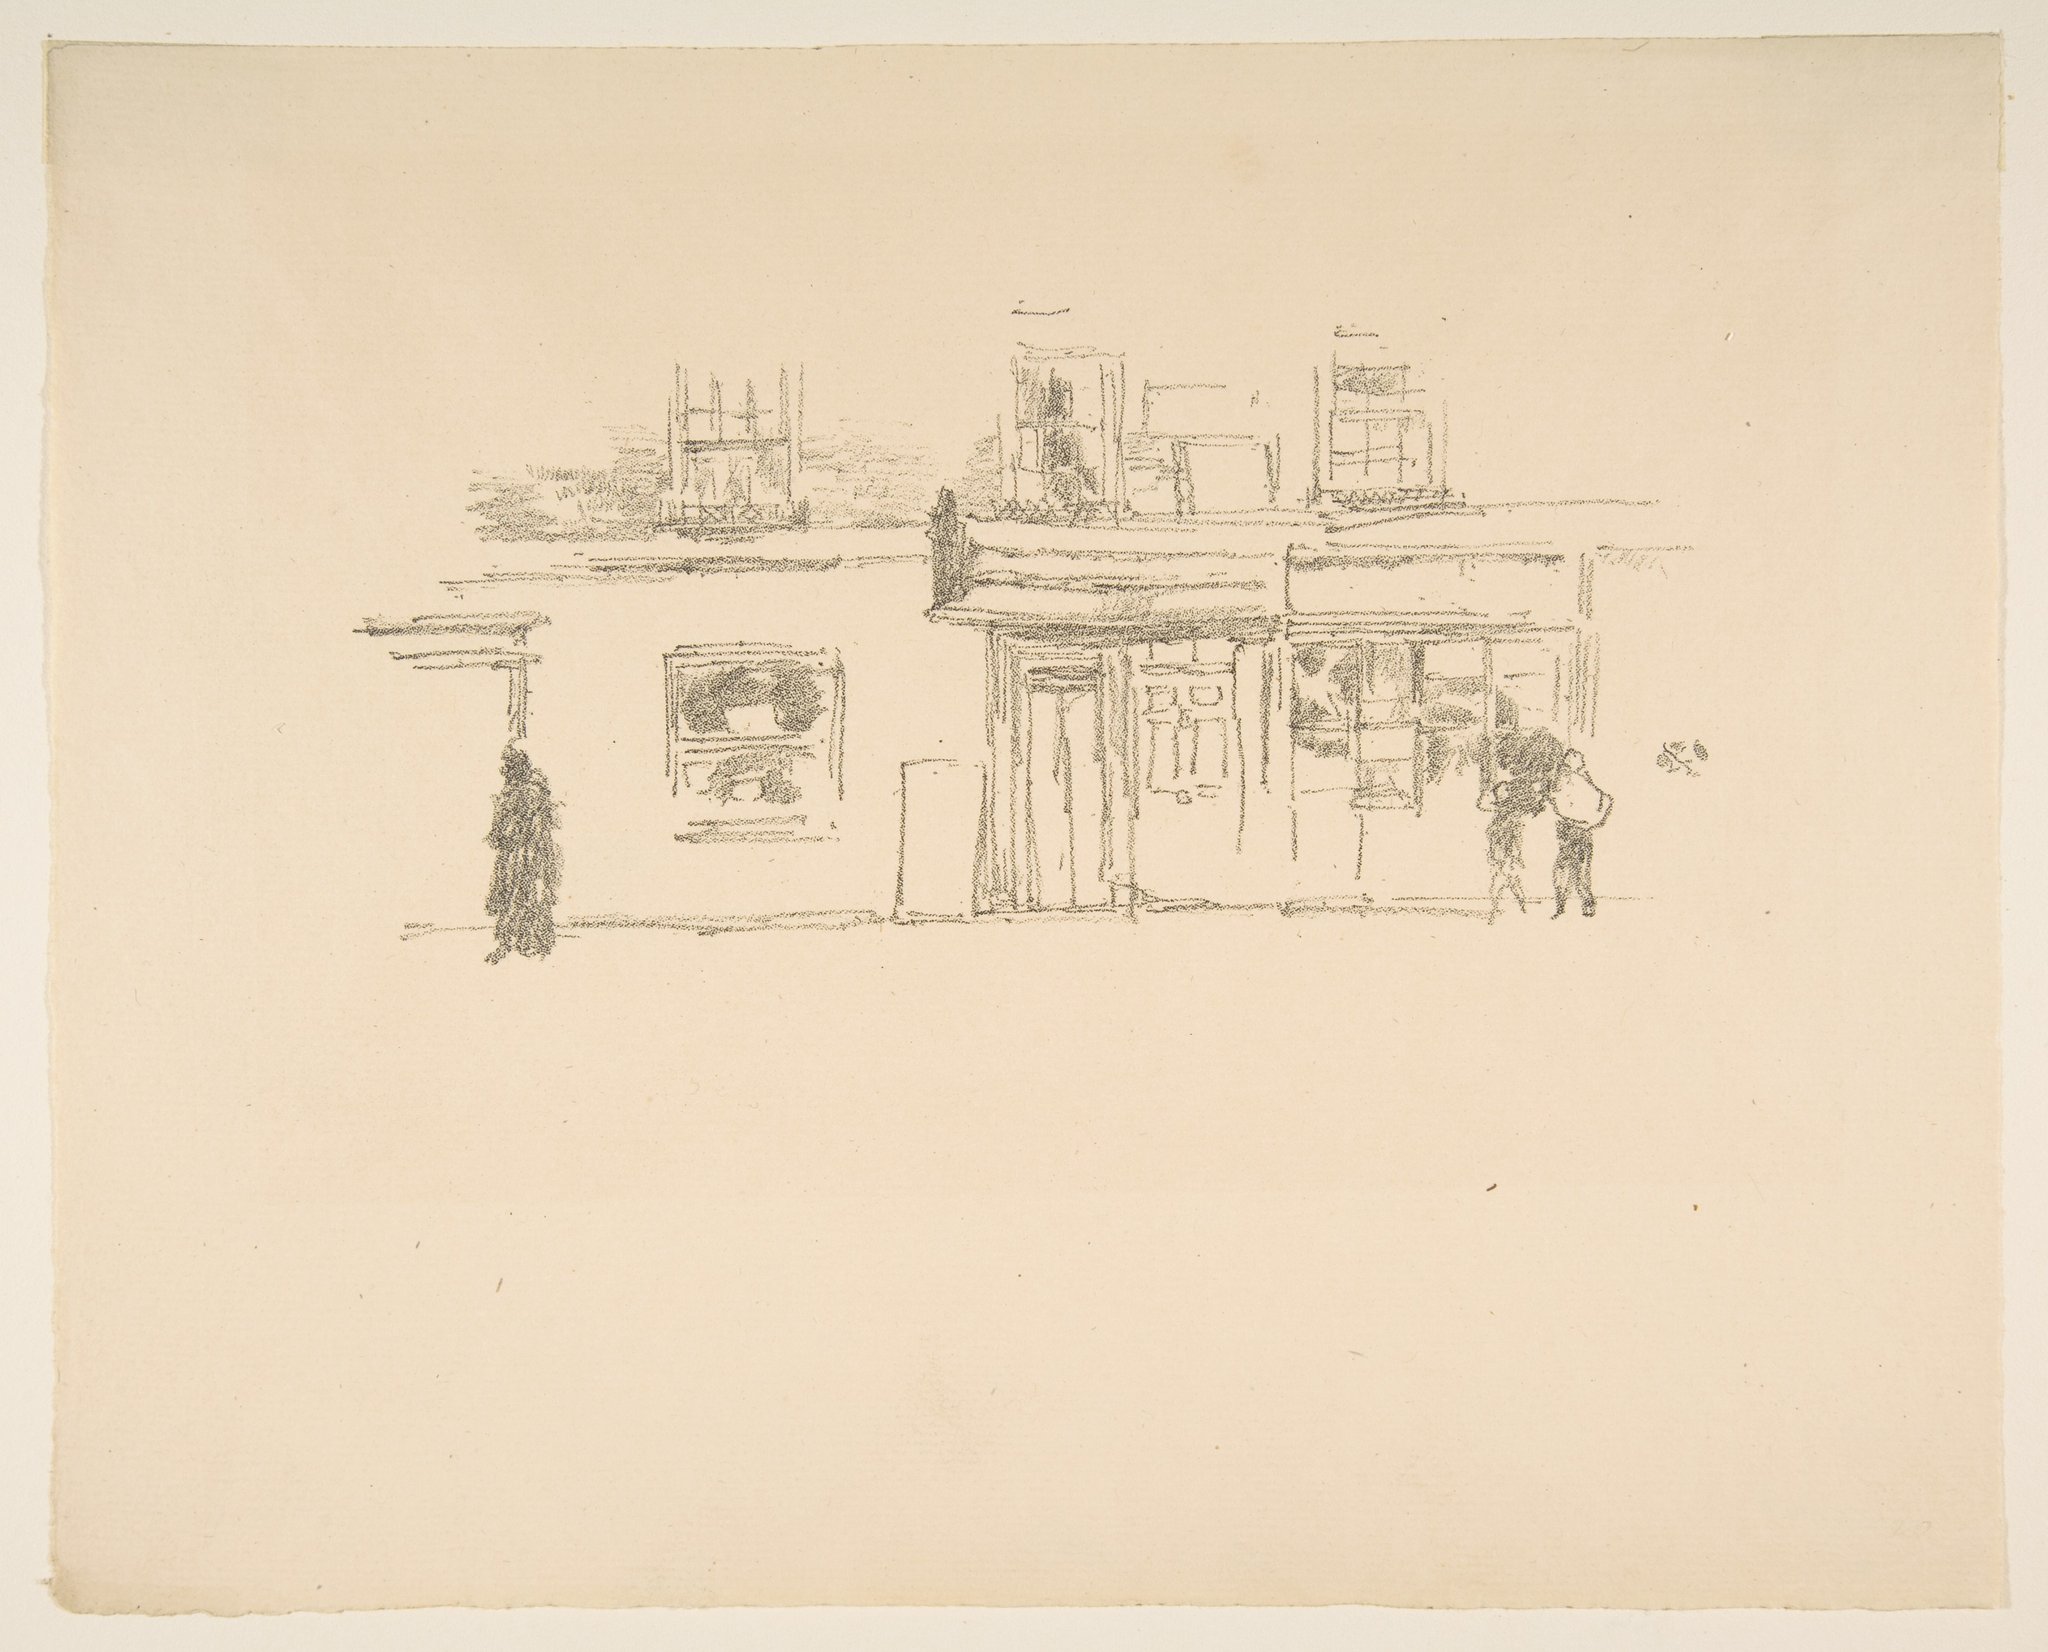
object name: print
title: Chelsea Shops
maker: james mcneill whistler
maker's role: artist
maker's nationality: american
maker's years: 1834-1903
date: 1888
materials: ink, paper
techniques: printing, lithography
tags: buildings